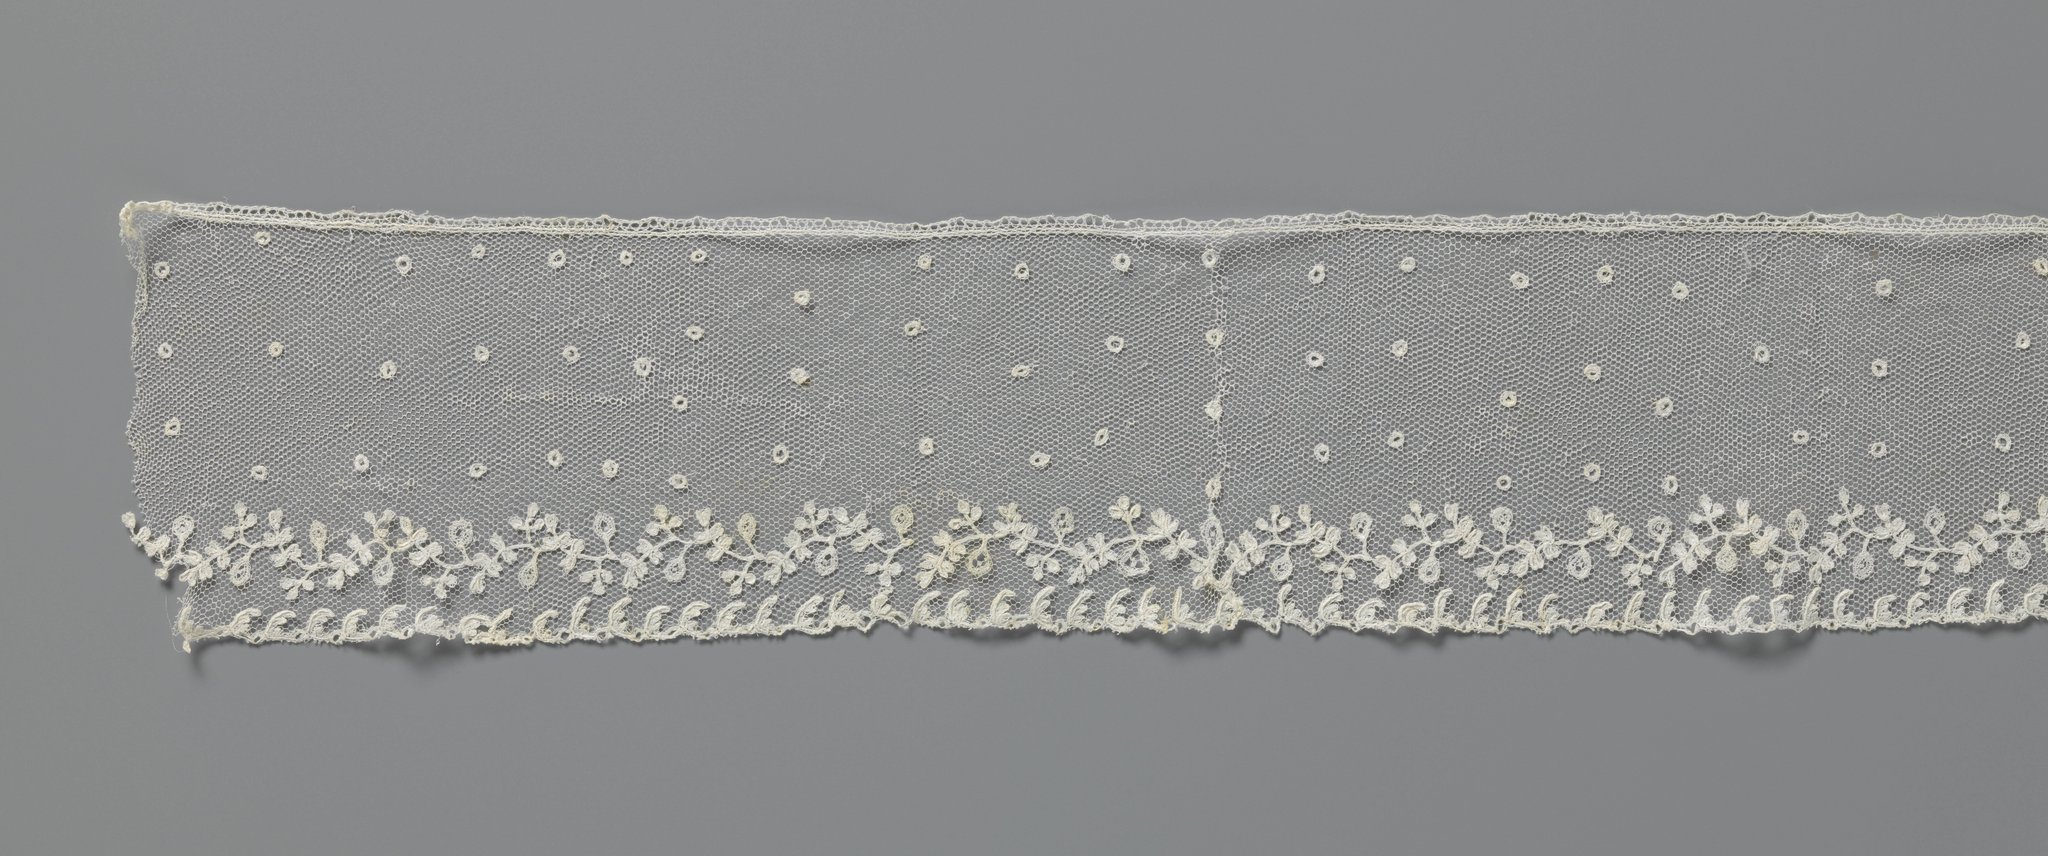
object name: strip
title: Strook applicatiekant met golvende rank en ronde knopjes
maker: Anonymous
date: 1800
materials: linen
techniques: lace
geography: brussels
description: Strook naturelkleurig applicatiekant: Brusselse kloskant geappliceerd op drochelgrond. Dit type kant staat ook bekend onder de naam: point d'Angleterre. Strooipatroon met open moesjes. Langs de fijn geschulpte onderrand van sikkelbladeren loopt een golvende rank waaraan ronde knopjes en diep ingesneden bladeren. Motieven van Brusselse kloskant met de typerende ribben ofwel gekloste reliëfcontouren. Eén soort open siersteek. De bovenzijde is afgezet met een rand kloskant.